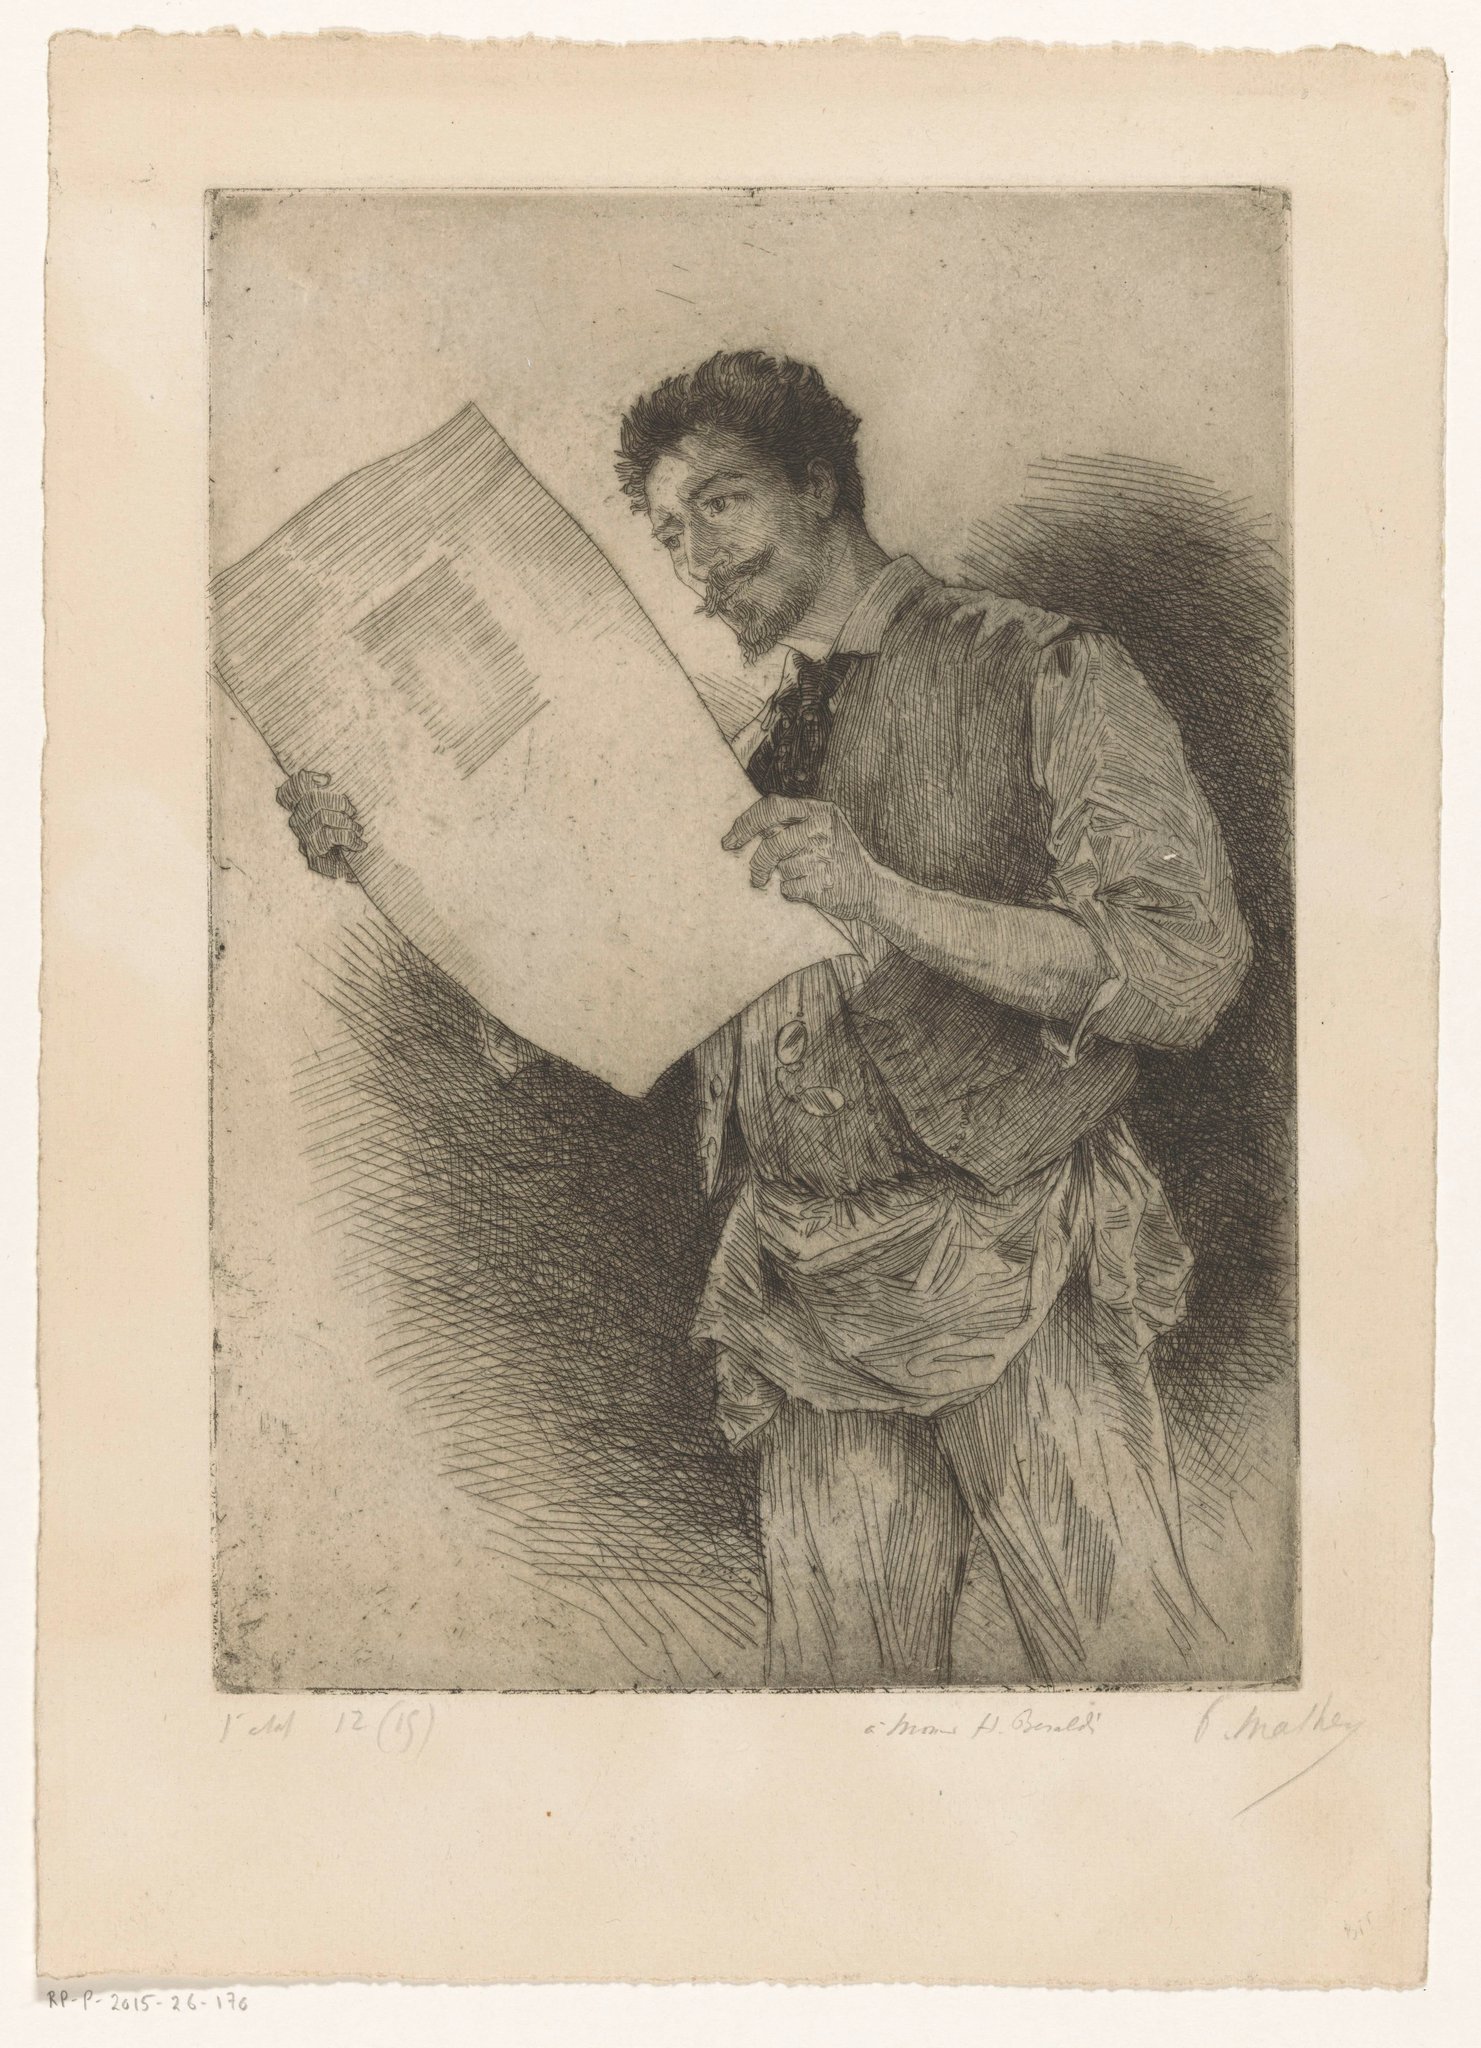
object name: print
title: Portret van Félicien Rops in zijn atelier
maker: paul mathey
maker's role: print maker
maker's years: 1844-1929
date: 1875-1900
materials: paper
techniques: drypoint, intaglio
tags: draughtsman, félicien rops, print, e.g.: engraving, etching, lithograph, printing press, tools, implements of graphic artist, graphic artist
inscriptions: dedication: ‘à monsr. H. Beraldi’, collector's mark: Lugt 4780, collector's mark: Lugt 230, collector's mark: Lugt 2228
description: De prent kan worden vergeleken met een schilderij met dezelfde voorstelling (Château Versailles MV 6146), waarop het atelier van de kunstenaar te zien is. Eerste staat van deze prent, met opdracht aan verzamelaar Henri Beraldi.